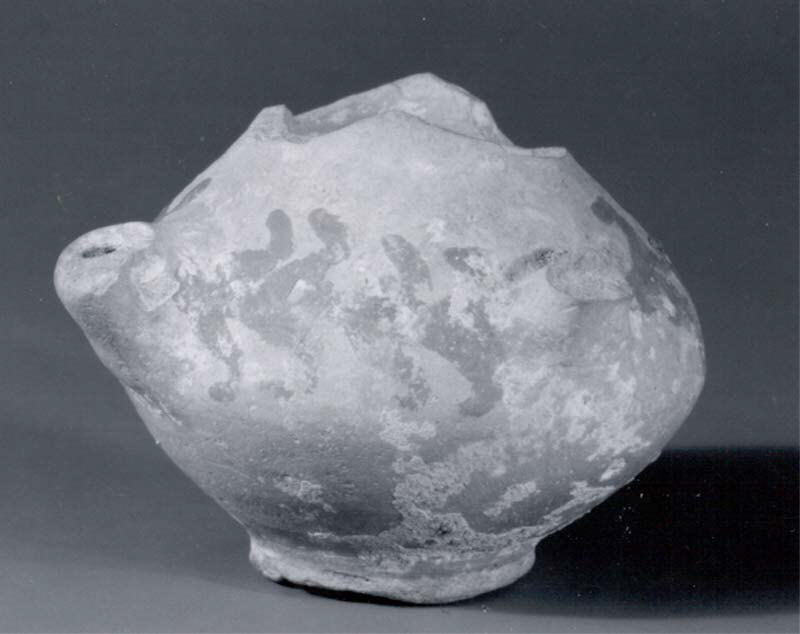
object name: vessel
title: Spouted vessel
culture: parthian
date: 1-100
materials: ceramic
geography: iran